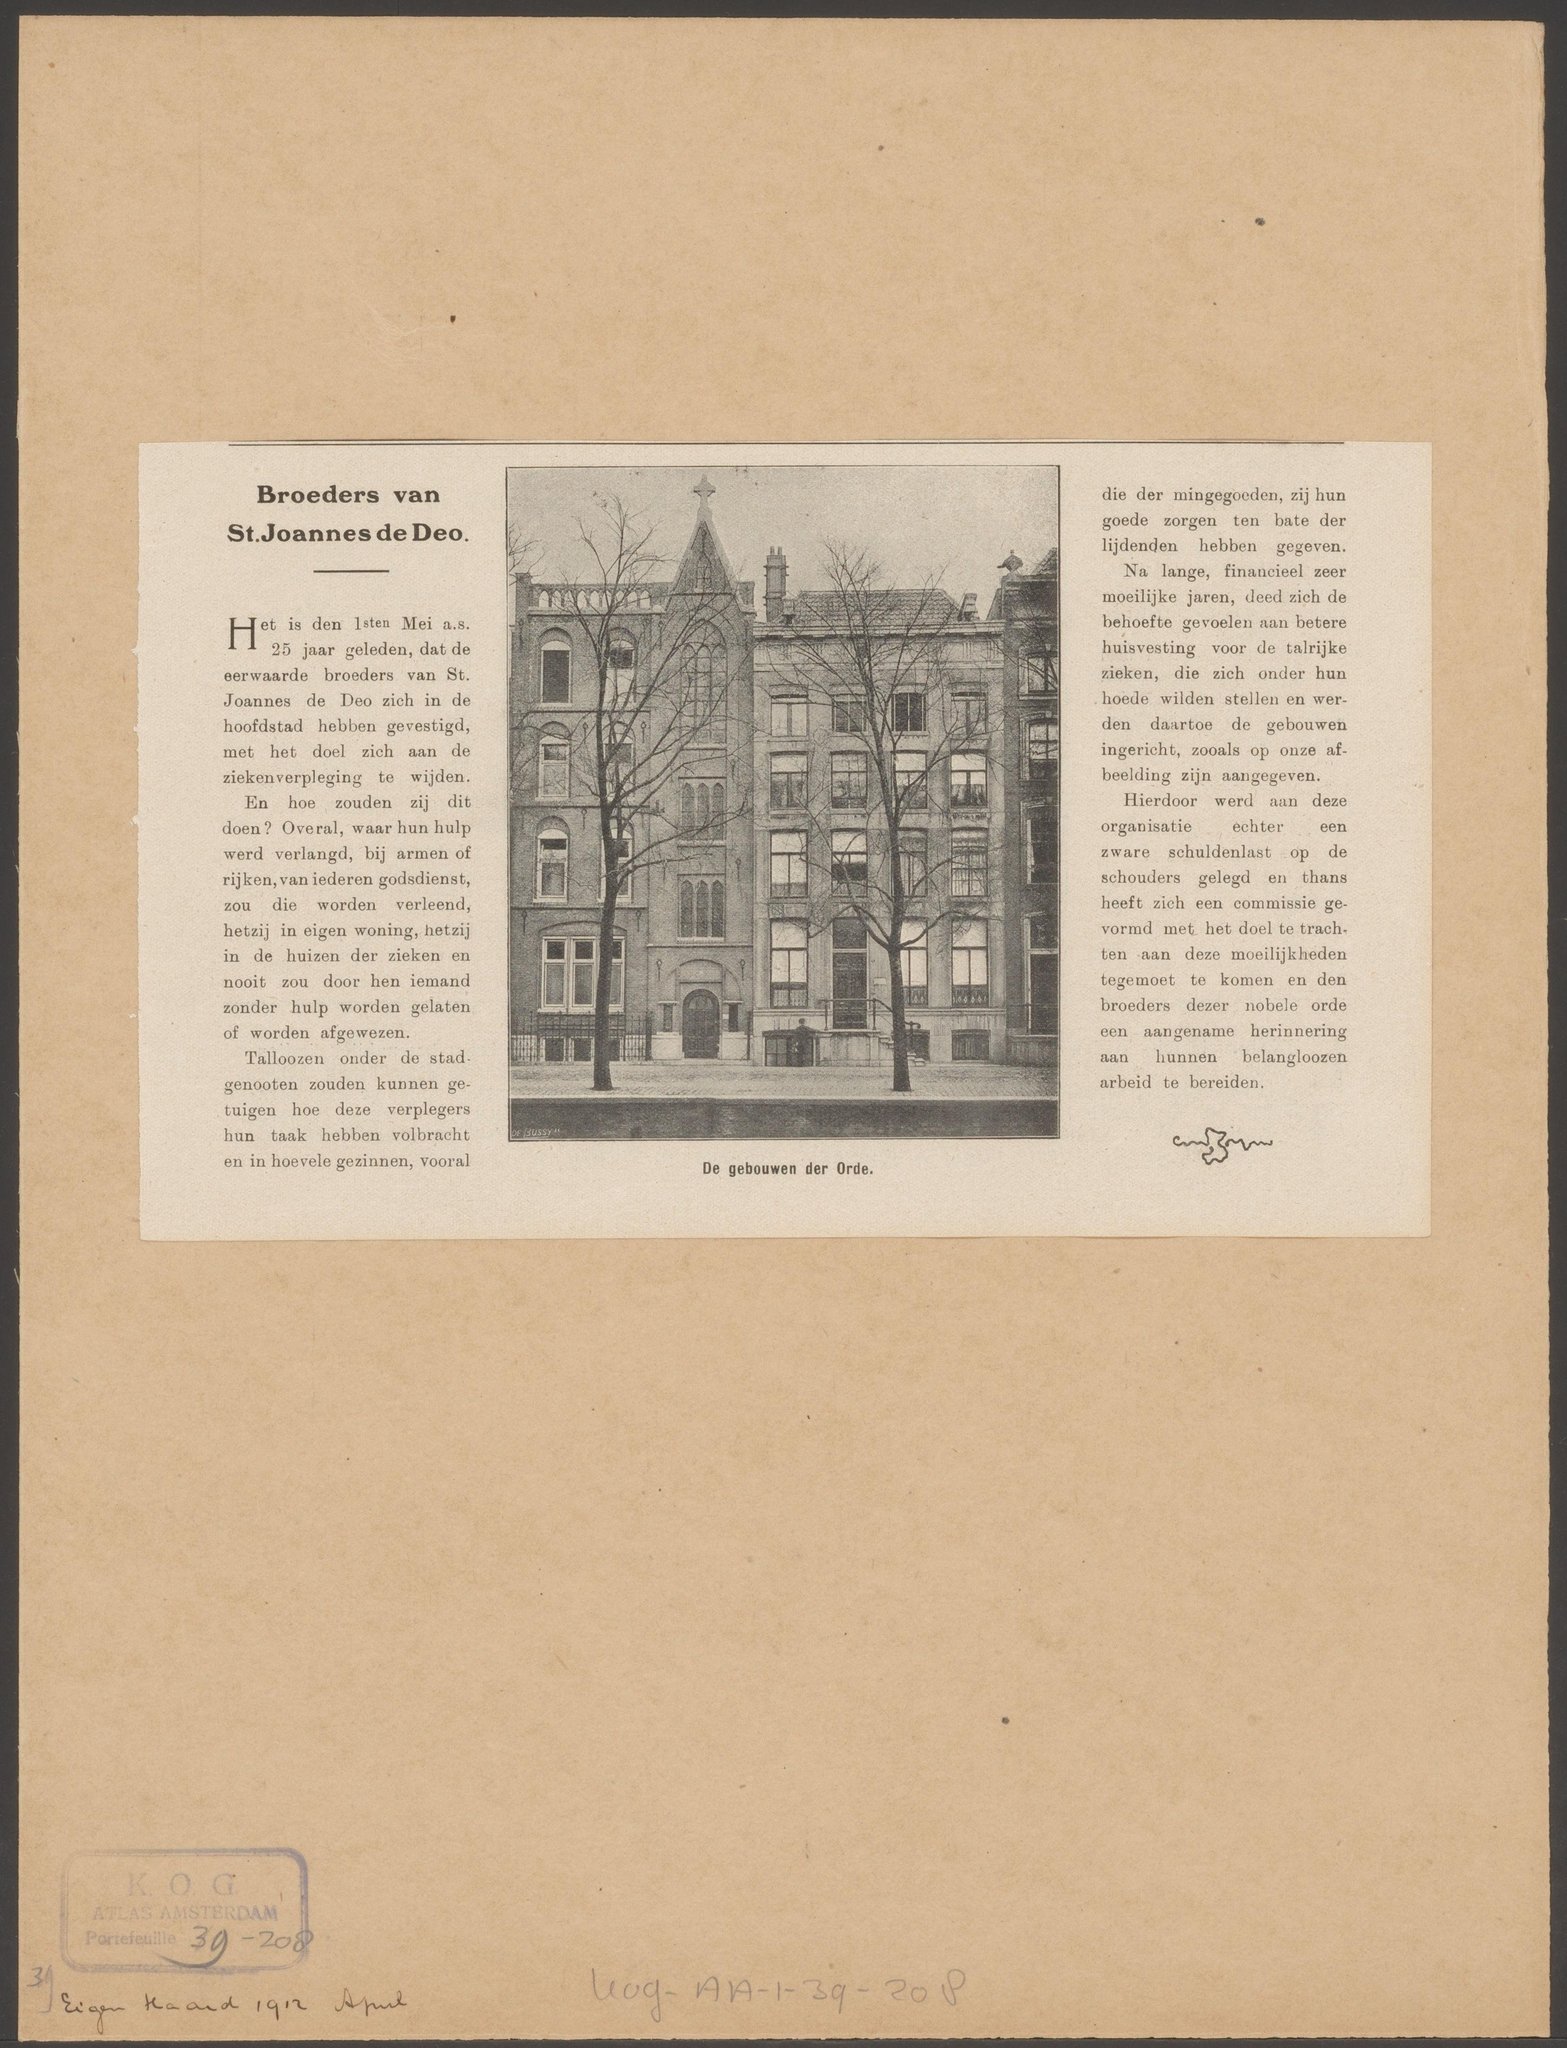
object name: photomechanical print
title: Gezicht op het tehuis van de Broeders van Barmhartigheid te Amsterdam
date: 1912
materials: paper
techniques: letterpress printing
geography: amsterdam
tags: hospital, street (+ city(-scape) with figures, staffage)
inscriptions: collector's mark: Lugt 1641b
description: Onderwerpsrubriek binnen de Atlas Amsterdam: Armwezen en liefdadige instellingen: V. Ziekenhuizen: Ver. voor Ziekenverpleging aan de Prinsengracht.